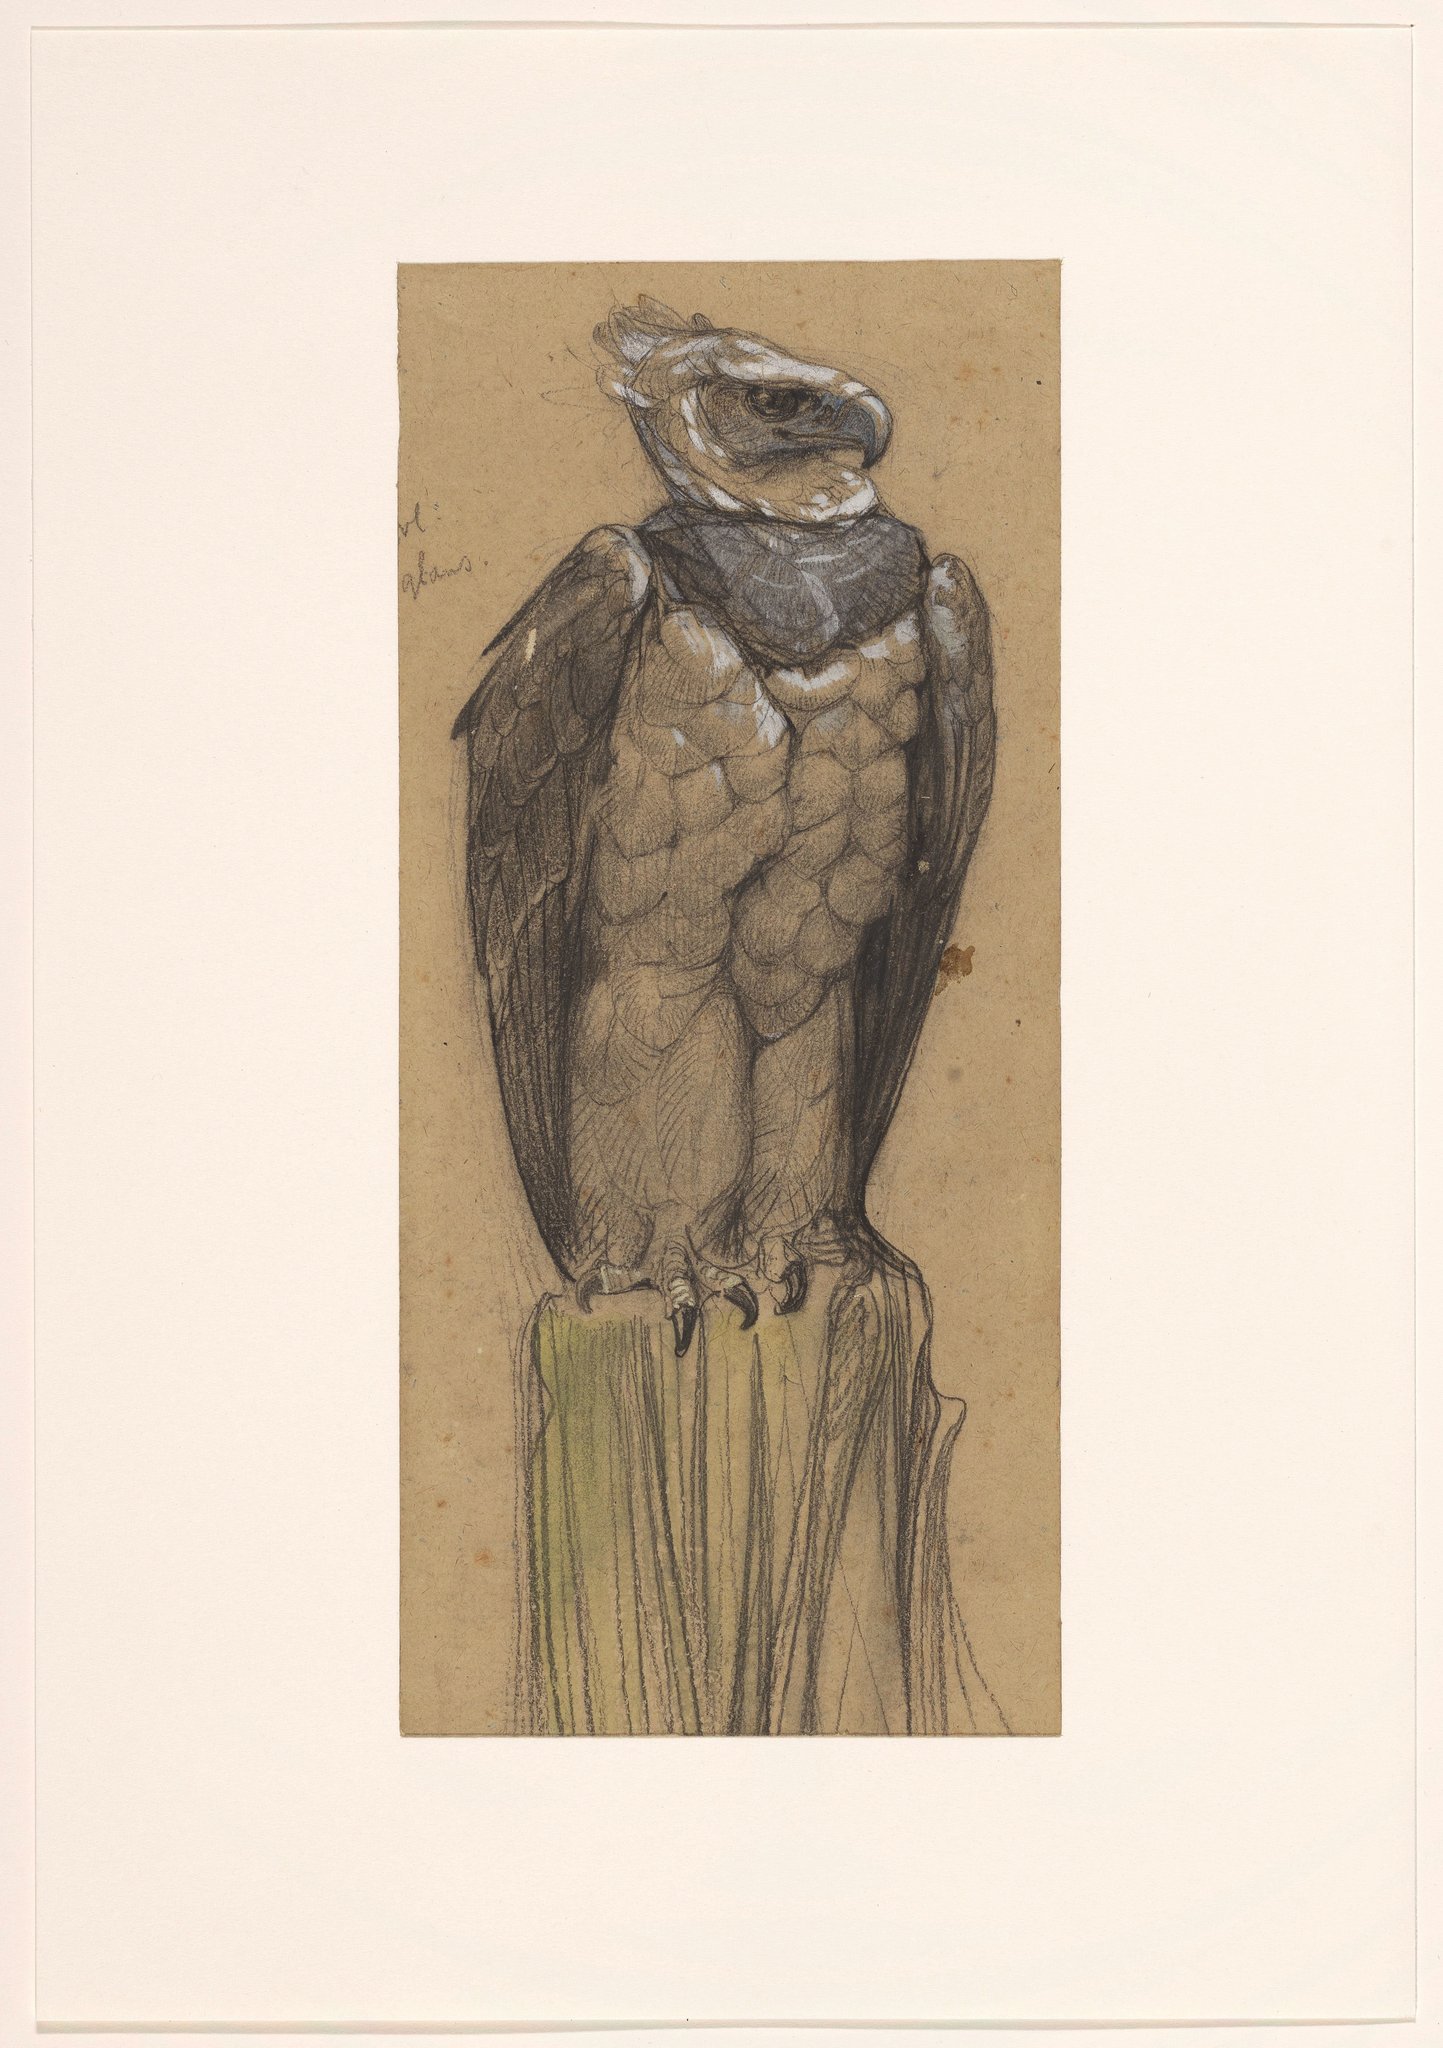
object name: drawing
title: Harpy Eagle (thrasaëtus harpyja)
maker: bernard willem wierink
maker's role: draughtsman, print maker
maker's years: 1856-1939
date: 1902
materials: chalk, paper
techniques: brush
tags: predatory birds: harpy eagle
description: Like his teacher August Allebé, Bernard Willem Wierink went to Artis Zoo almost daily to sketch all kinds of animals. According to him, the beauty of nature was not solely to be found in a bird of paradise, but also in less attractive animals, such as this ill-tempered looking harpy eagle. The manner in which he drew the lines – first sketchily, and then with greater control and even stylized – is typical of his book illustrations.